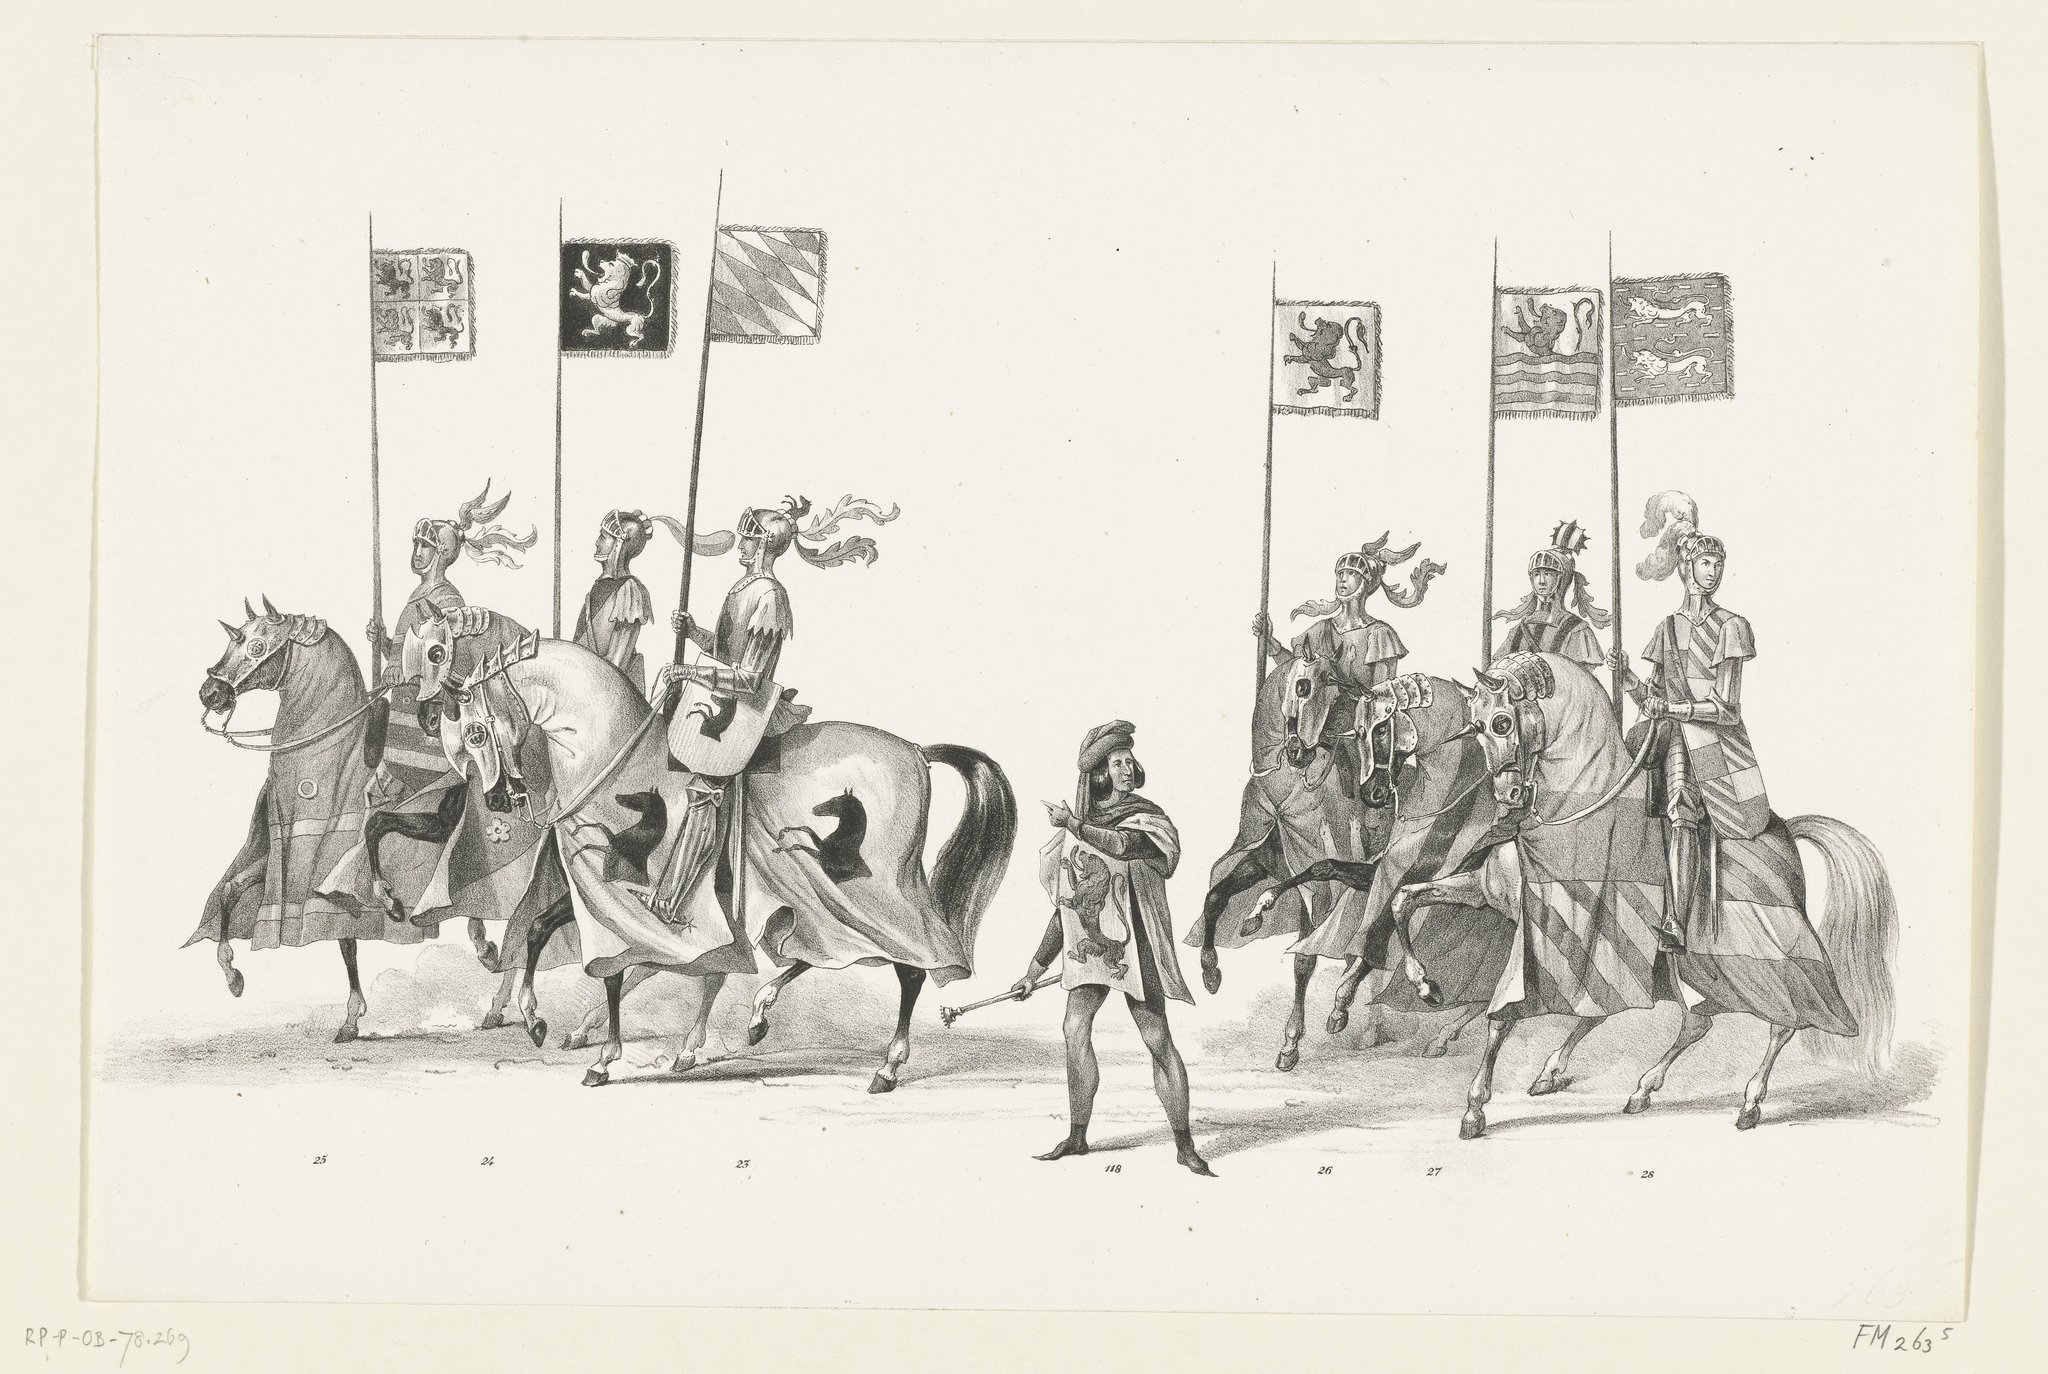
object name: print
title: Optocht nrs 25-28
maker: Anonymous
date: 1840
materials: paper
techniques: lithograph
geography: netherlands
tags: jan van beieren, students' pageant, triumphal entry and public reception, pageant, 'entrée solennelle', 'joyeuse entrée', leiden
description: Optocht nrs 25-28: ridders met banieren. Onderdeel van de prentserie van de Maskerade van de intocht van hertog Jan van Beieren te Leiden op 18 augustus 1420 door de Leidse studenten op 8 februari 1840.